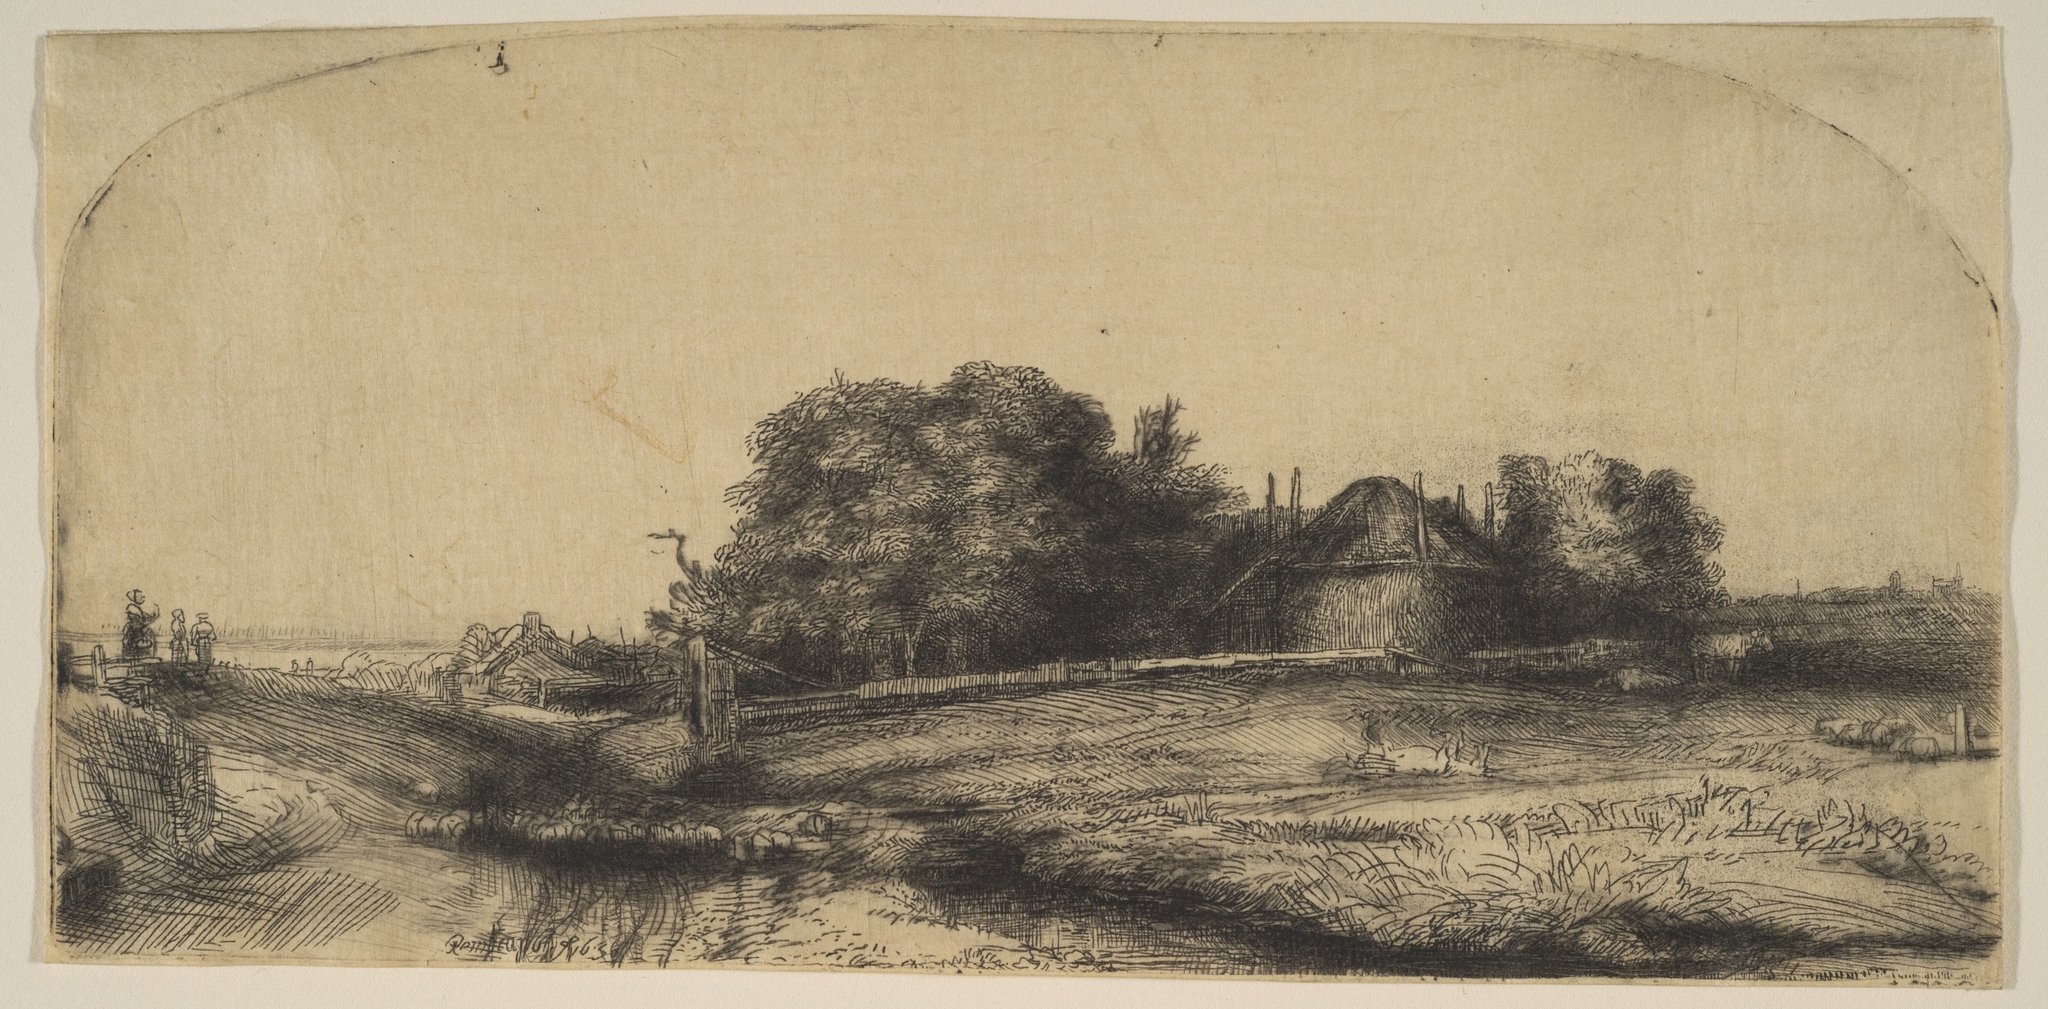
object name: print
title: Cottages and a Hay Barn on the Diemerdijk with a Flock of Sheep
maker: rembrandt van rijn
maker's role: artist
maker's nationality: dutch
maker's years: 1606-1669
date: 1652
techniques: drypoint, etching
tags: barns,landscapes